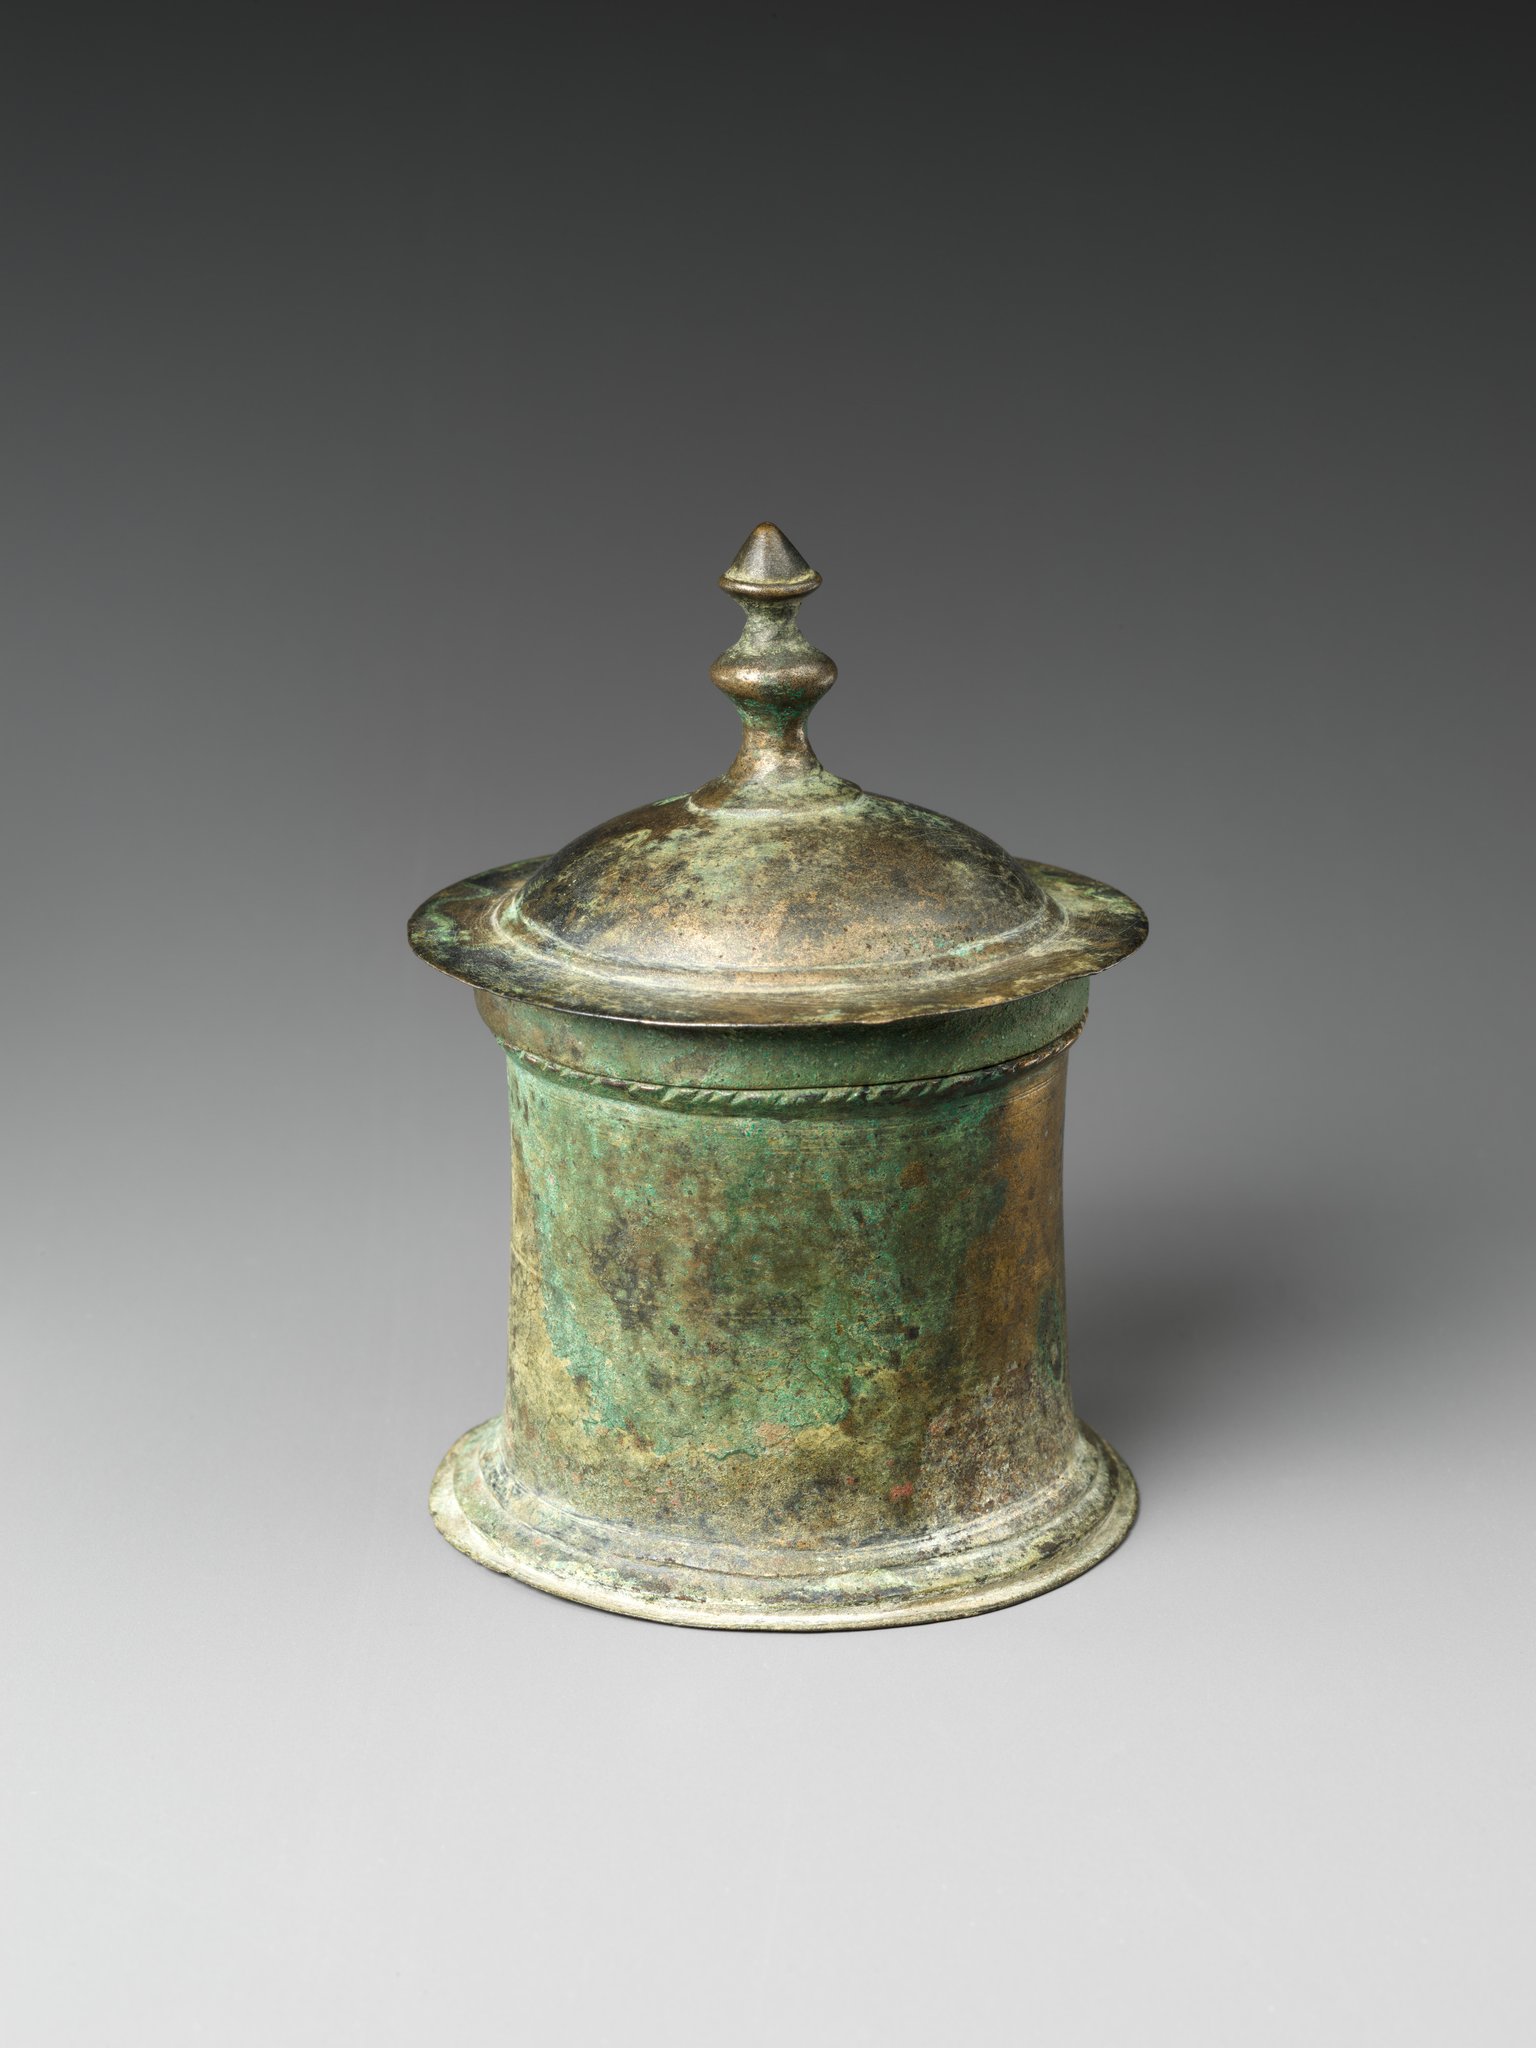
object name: reliquary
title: Covered Reliquary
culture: gandhara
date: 1-100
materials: bronze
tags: gandhara